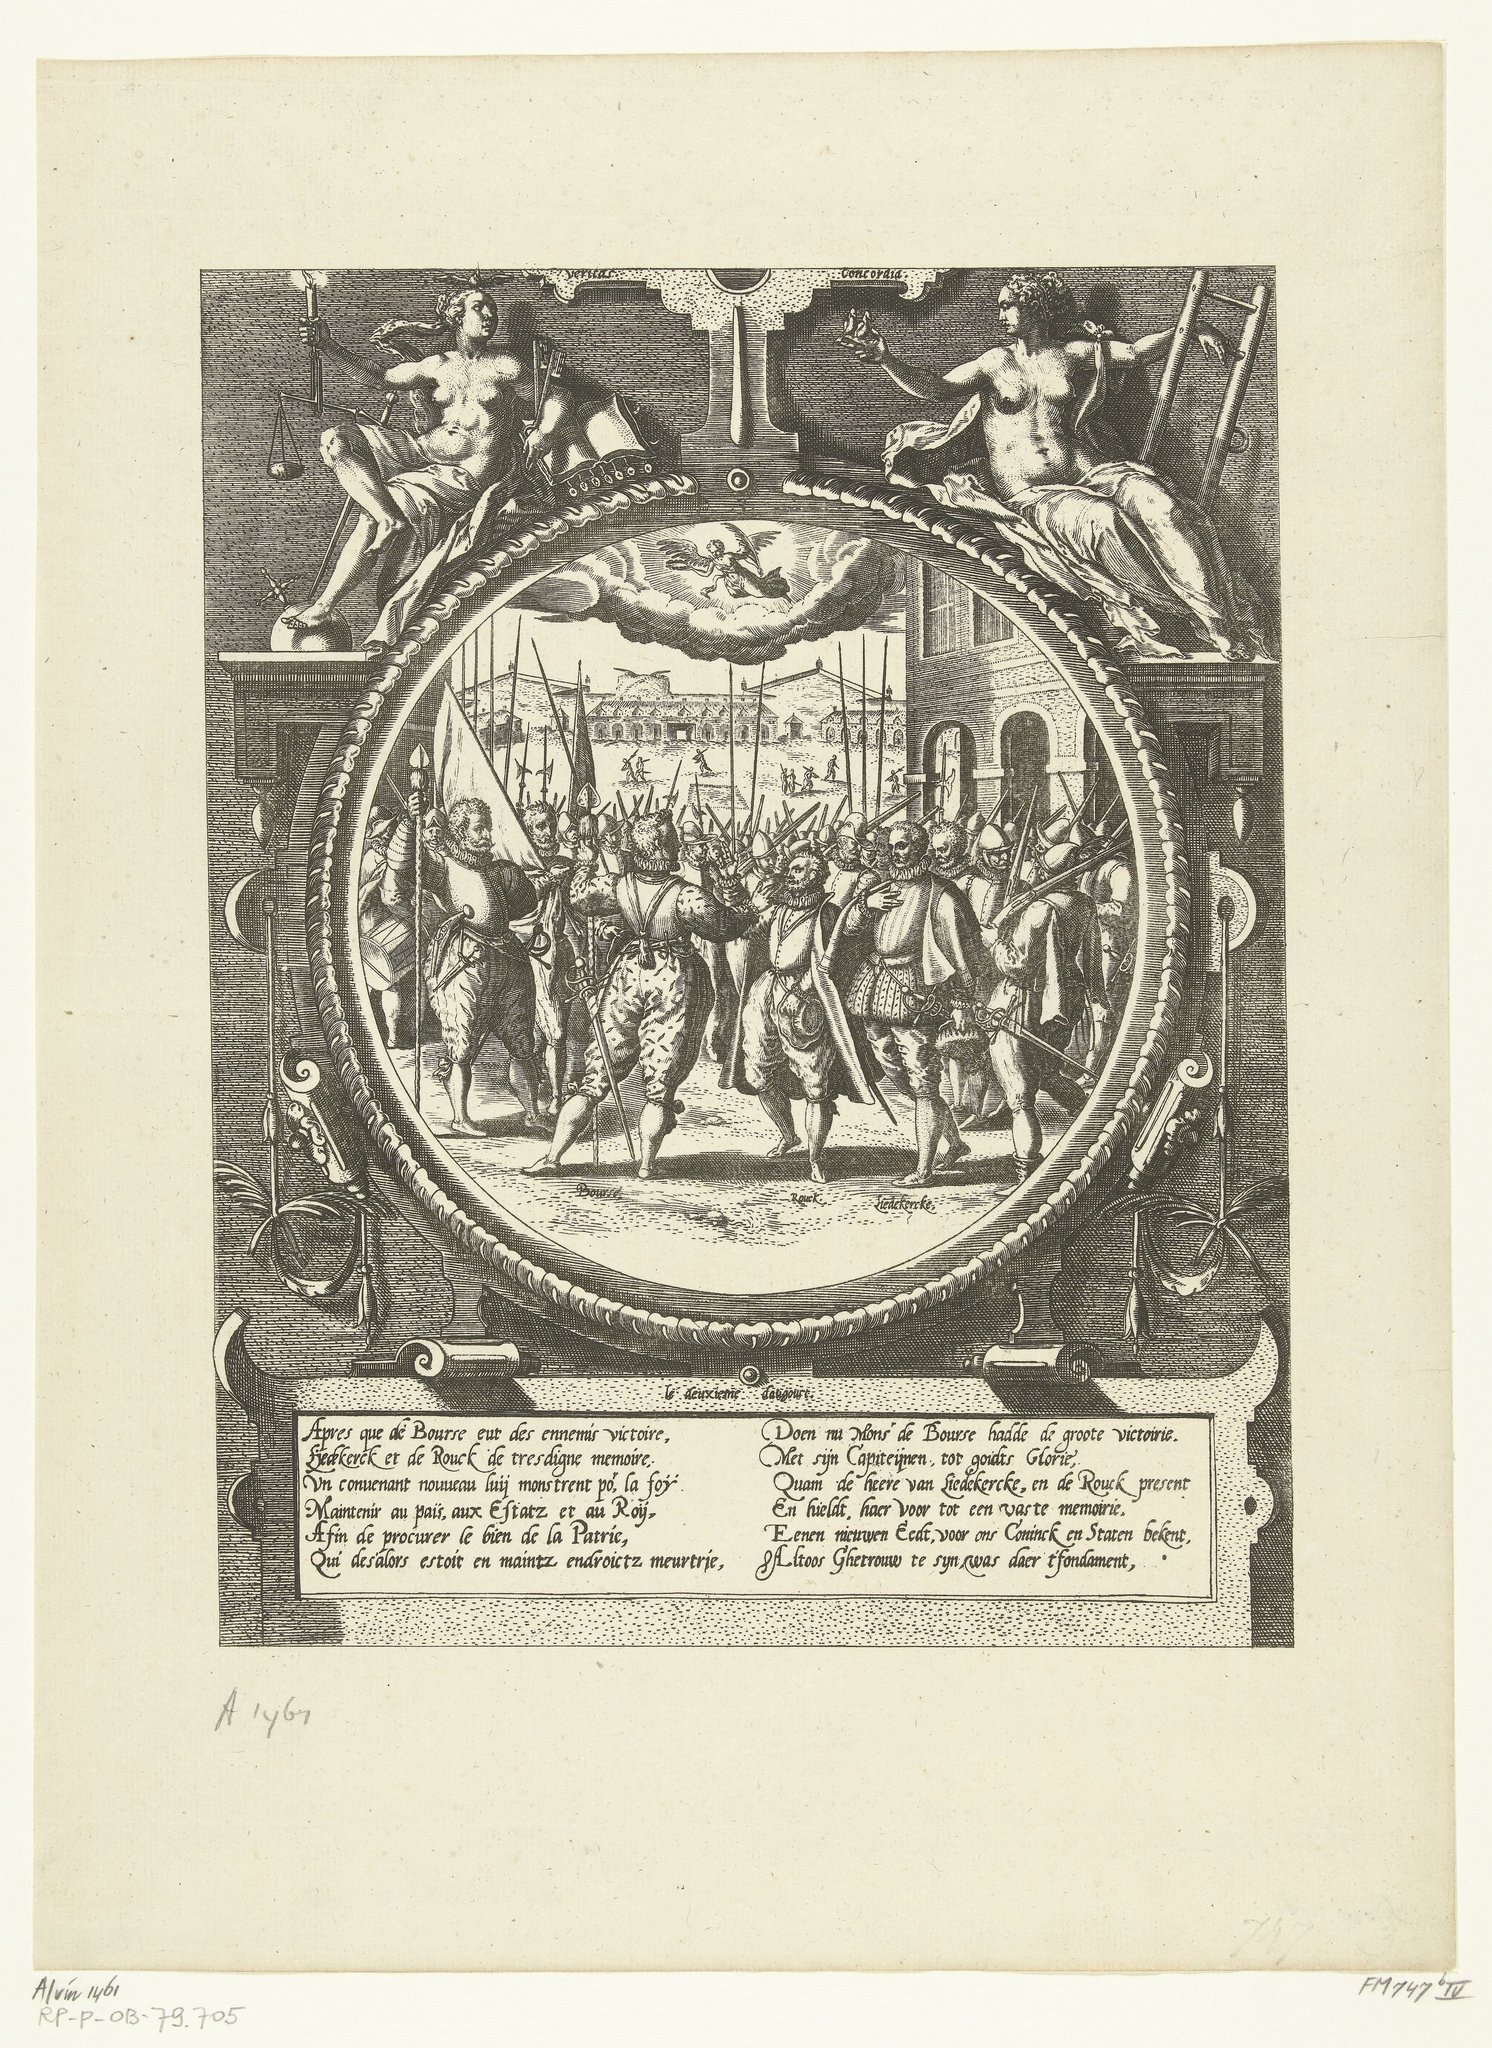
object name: historical object representation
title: Reproductie van de prent waarop Bourse, Liedekercke en Roeck hun eed bevestigen, 1577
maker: william stirling maxwell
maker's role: politician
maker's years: 1818-1878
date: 1877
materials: paper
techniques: photolithography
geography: great britain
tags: agreement, unity; 'concordia', 'concordia insuperabile', 'concordia militare', 'concordia di pace', 'unione civile' (ripa), truth; 'verità' (ripa), swearing an oath (with two fingers raised)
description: Reproductie van de prent waarop Bourse, Liedekercke en Roeck hun eed bevestigen, 2 augustus 1577. De drie heren omringd door soldaten leggen een eed af. In de wolken een engel met lauwerkrans en palmtak. Voorstelling in een rond medaillon met ornamentele allegorische omlijsting met bovenaan de zittende vrouwelijke personificaties van Waarheid (Veritas) en Eendracht (Concordia). Onderaan een cartouche met 2 verzen van elk 6 regels in het Frans en Nederlands.